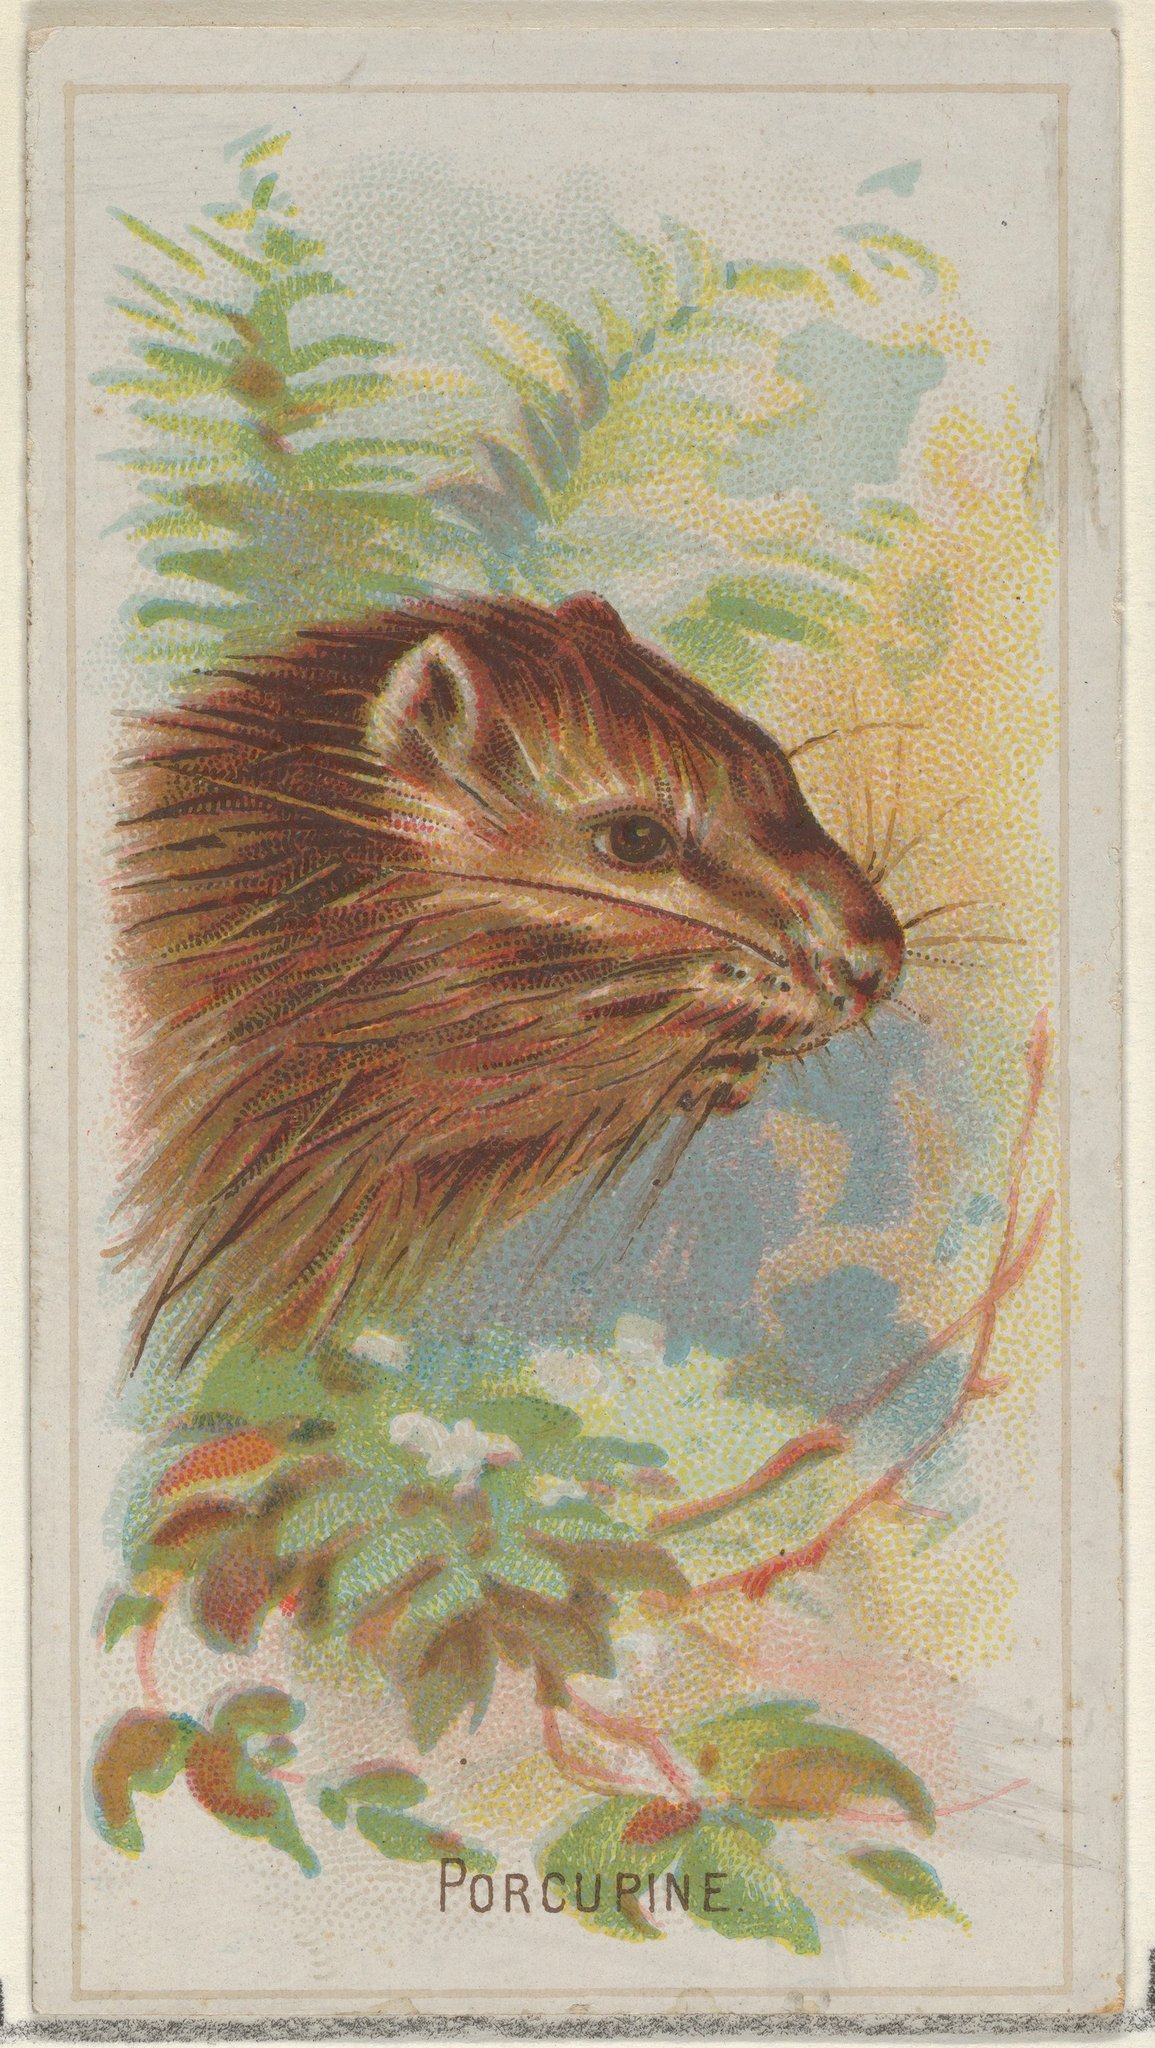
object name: print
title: Porcupine, from the Wild Animals of the World series (N25) for Allen & Ginter Cigarettes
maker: allen & ginter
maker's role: publisher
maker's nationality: american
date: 1888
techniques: color lithograph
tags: animals